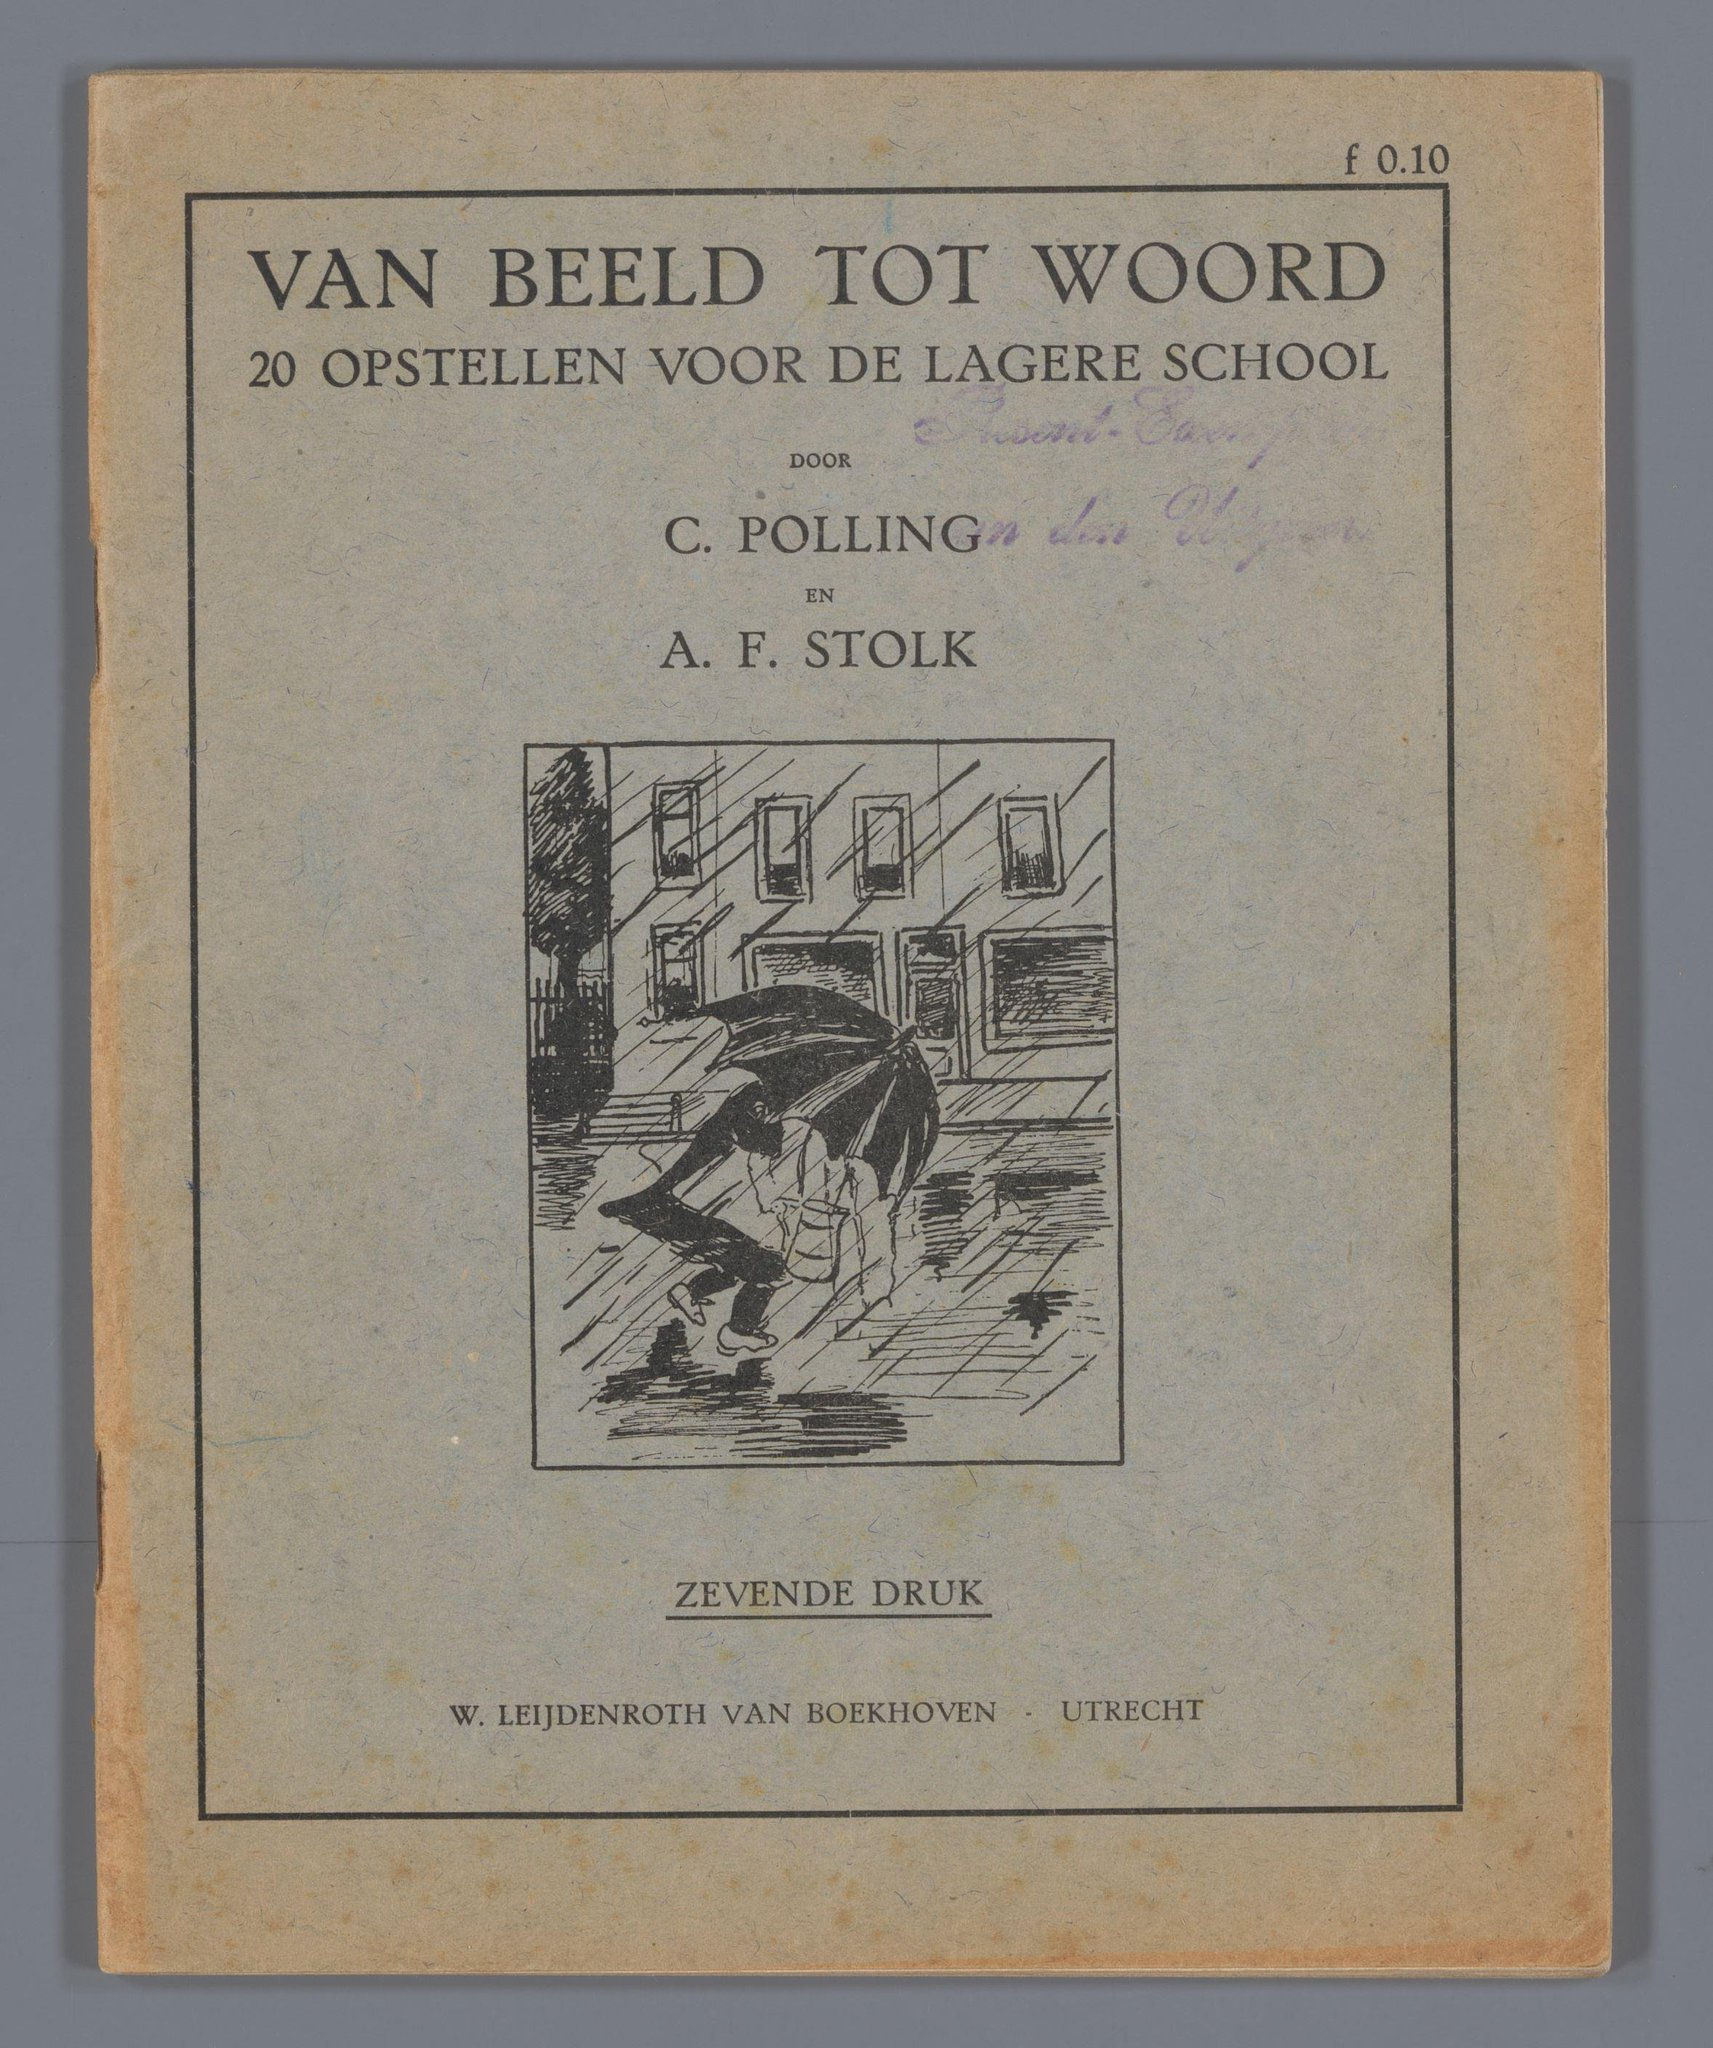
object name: schoolschrift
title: Van Beeld tot woord; 2 opstellen voor de lagere school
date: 1912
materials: ink, paper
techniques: printing, writing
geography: utrecht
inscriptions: date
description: Schrift met op de linkerpp. steeds vier tekeningen over één thema, in totaal 20 thema's. Bij verschillende tekeningen is op de rechterp. een opstel geschreven met de hand, in rood gecorrigeerd. Het boekje is bestemd voor de vierde klas van de lagere school; het betreft de 7de druk. Gedateerd.